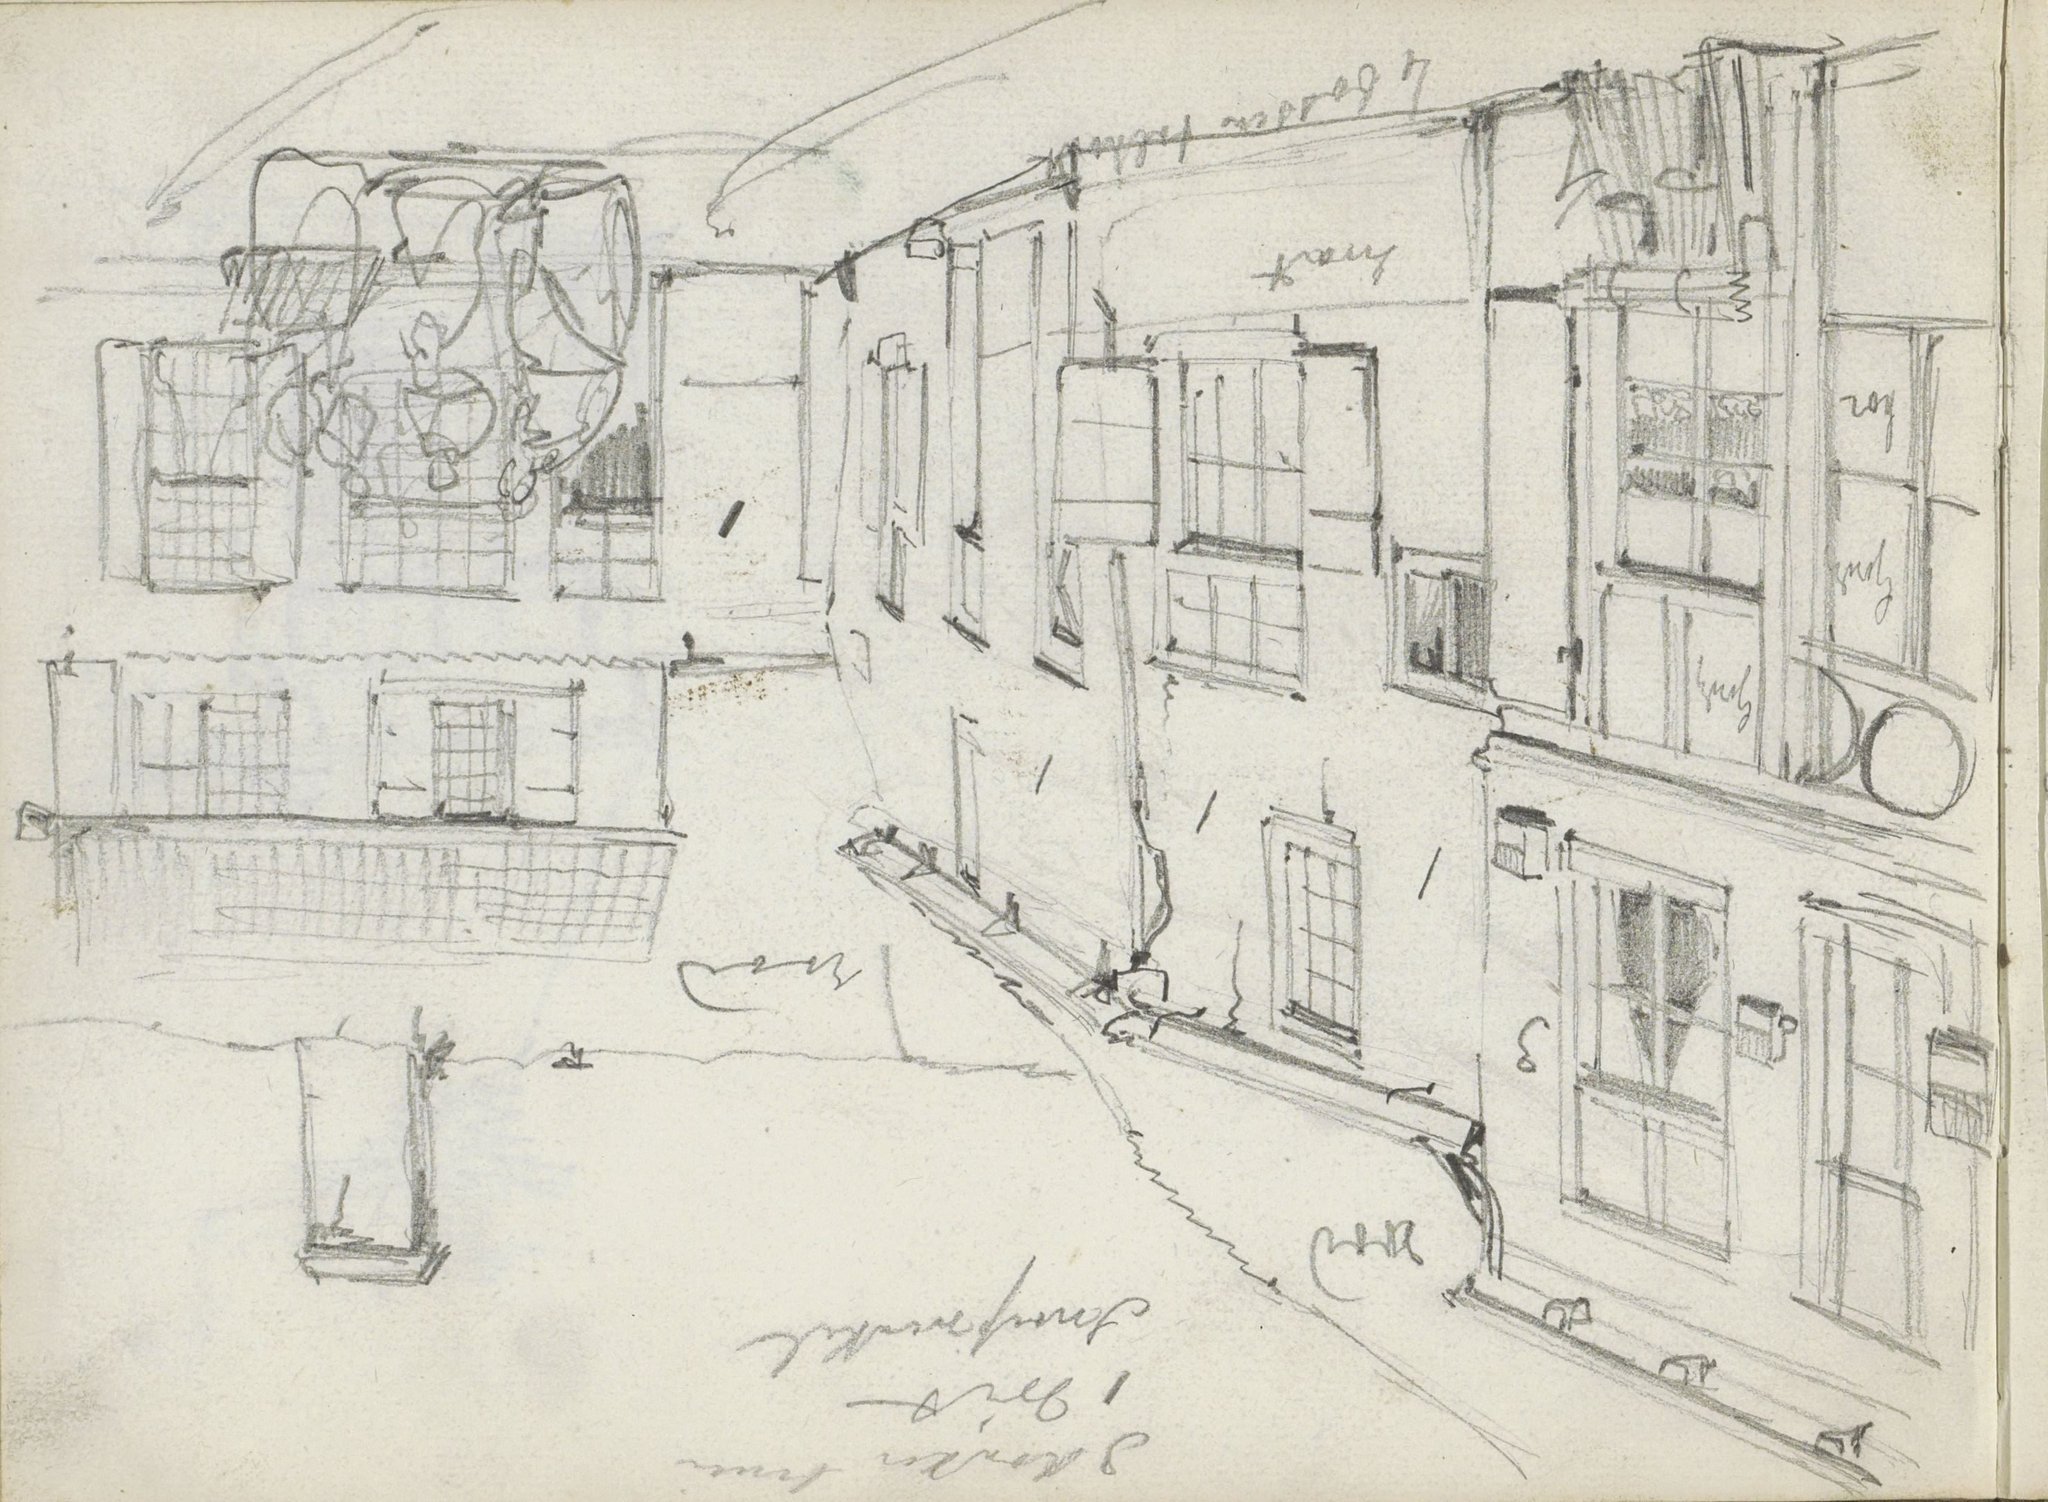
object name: sketchbook leaf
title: Dorpsstraat met figuren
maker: willem koekkoek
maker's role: draughtsman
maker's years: 1839-1895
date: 1849-1895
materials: paper, pencil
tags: village street (+ city(-scape) with figures, staffage)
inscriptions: kleurnotitie, handgeschreven in potlood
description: Pagina 10 verso uit een schetsboek met 26 bladen.